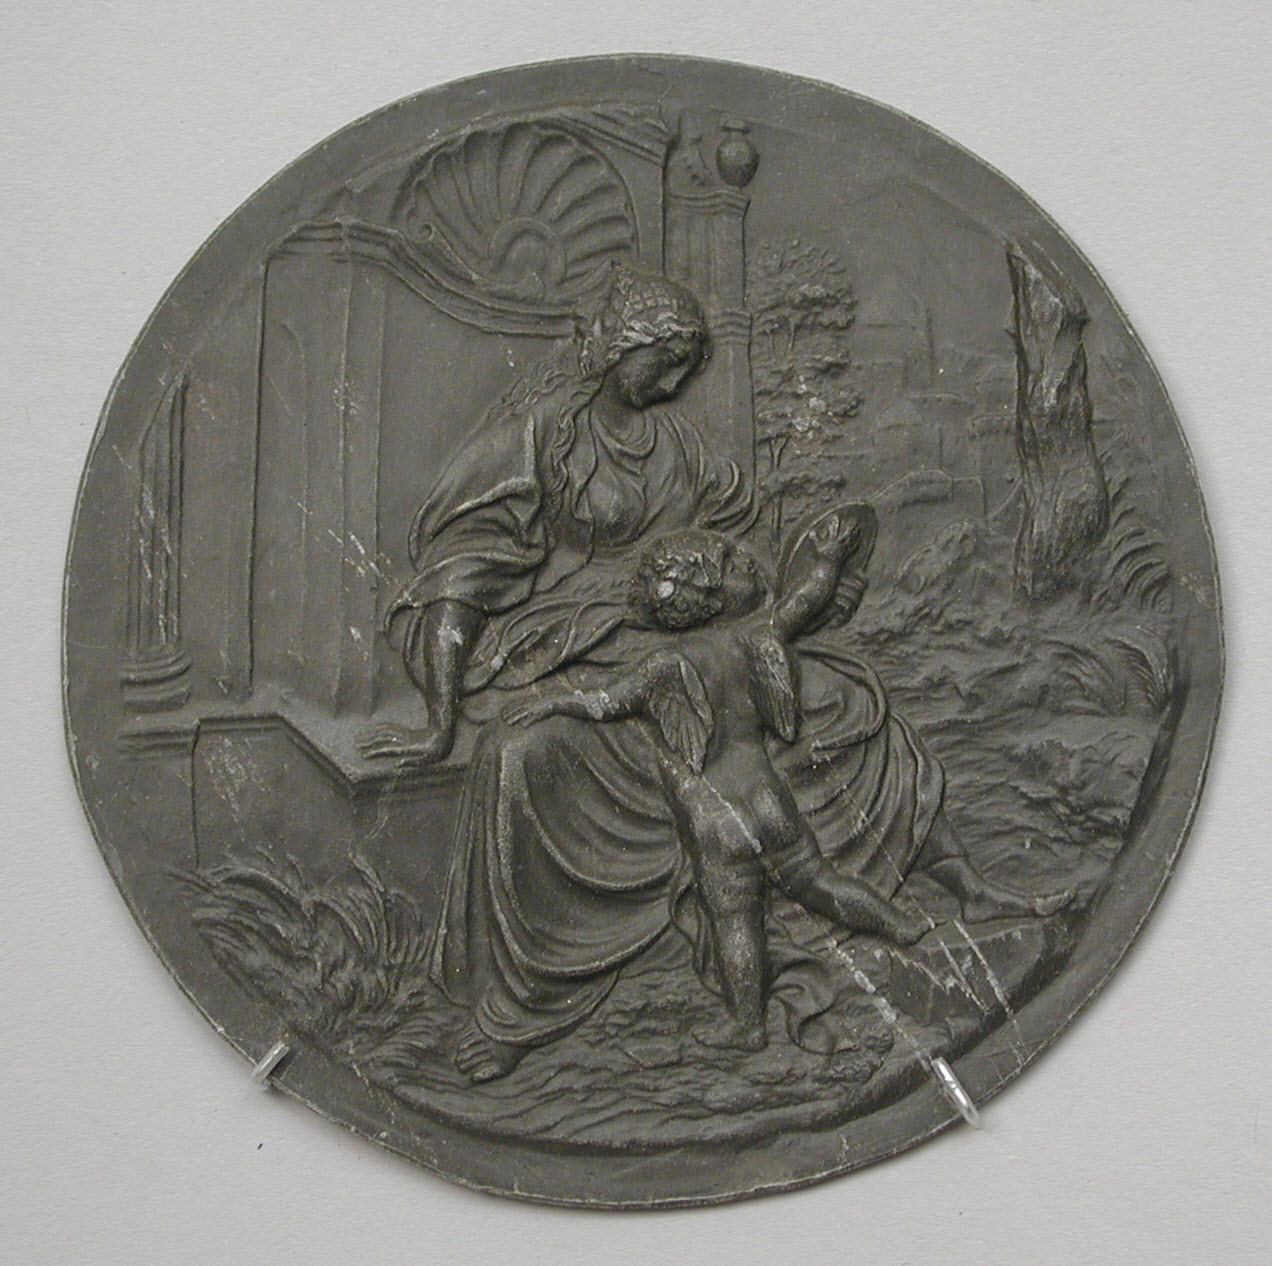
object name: plaquette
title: Prudence seated with an amorino and a mirror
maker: peter flötner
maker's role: artist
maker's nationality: german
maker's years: 1485-1546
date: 1501-1600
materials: lead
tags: women,putti